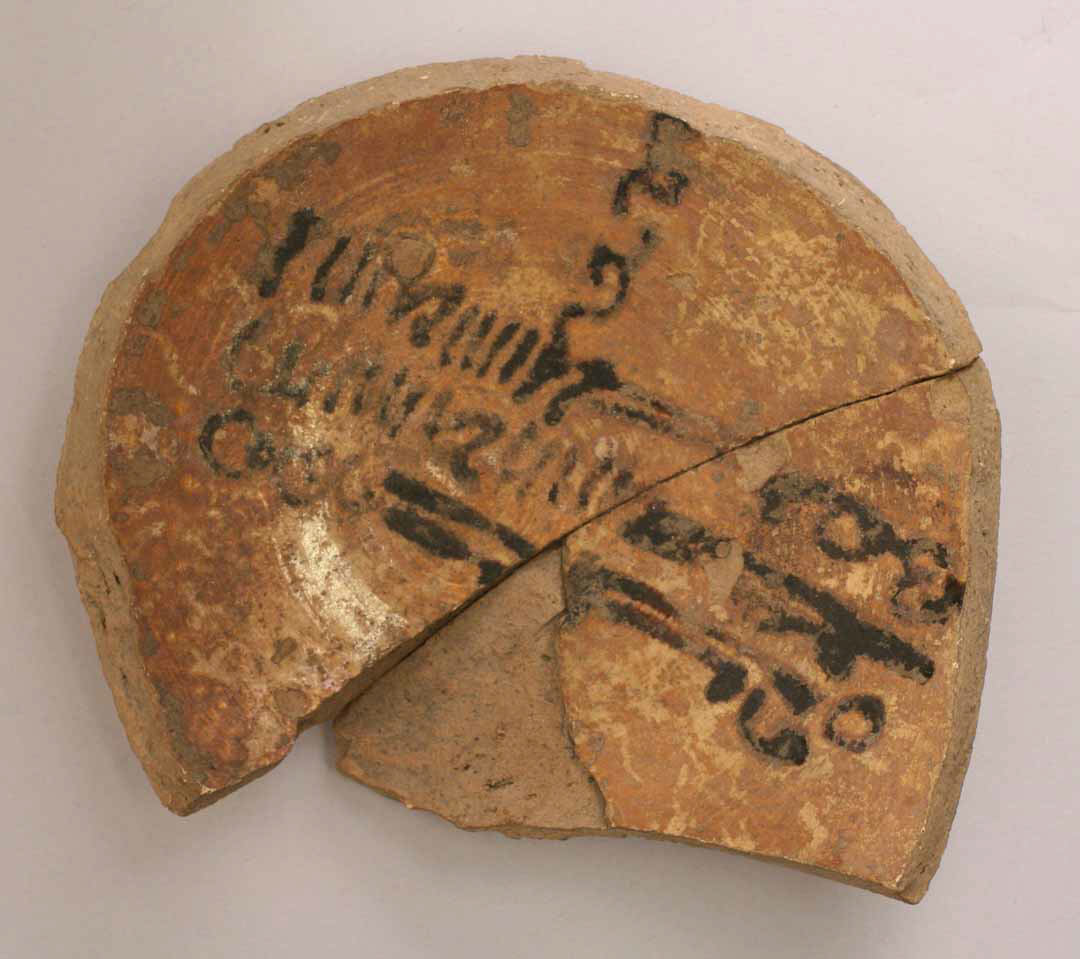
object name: fragment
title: Fragment of a Bowl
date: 601-800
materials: earthenware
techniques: painting, underglaze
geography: iran